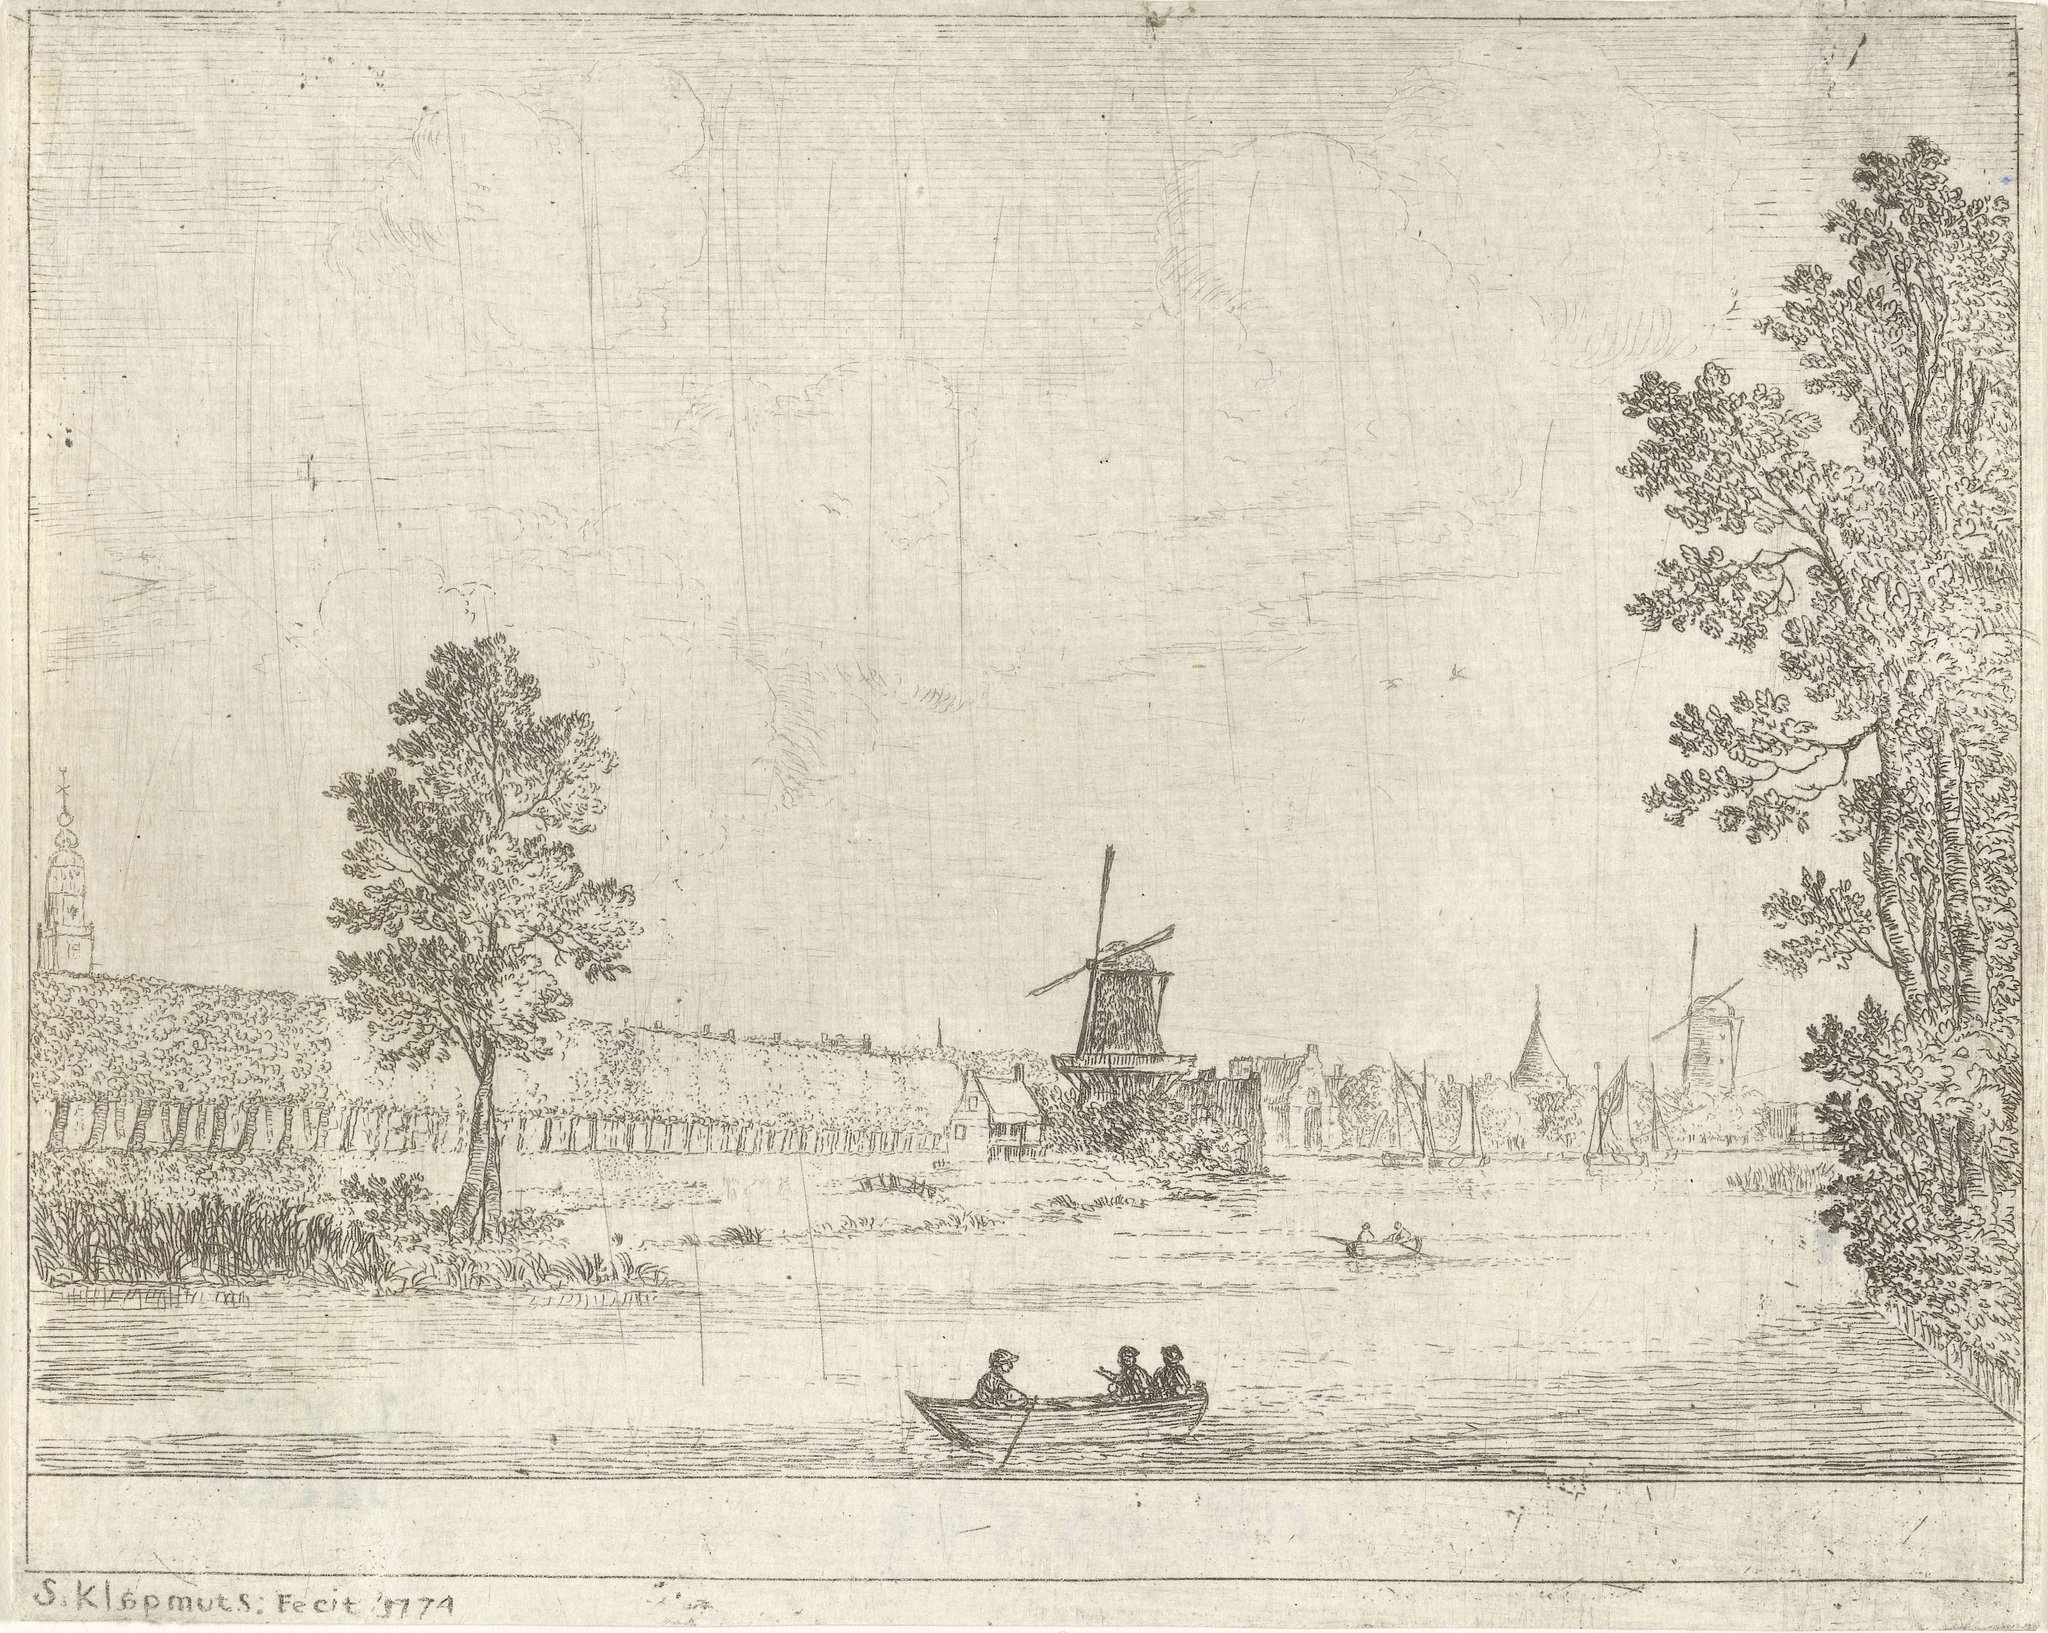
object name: print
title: Molens aan het water bij Gouda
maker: simon klapmuts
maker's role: print maker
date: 1774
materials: paper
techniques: etching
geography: moordrecht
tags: prospect of city, town panorama, silhouette of city - ii - ideal city, river, rowing-boat, canoe, etc., windmill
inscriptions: collector's mark: Lugt 2165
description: Twee molens aan de oever van de Hollandse IJssel, waarop boten varen. Op de achtergrond zijn de contouren van een stad zichtbaar met stadspoort en toren, waarschijnlijk Gouda. Links de Schielands Hoge Zeedijk tussen Moordrecht en Gouda, de twee molens zijn de korenmolen de Waterhondt en molen 't Slot.